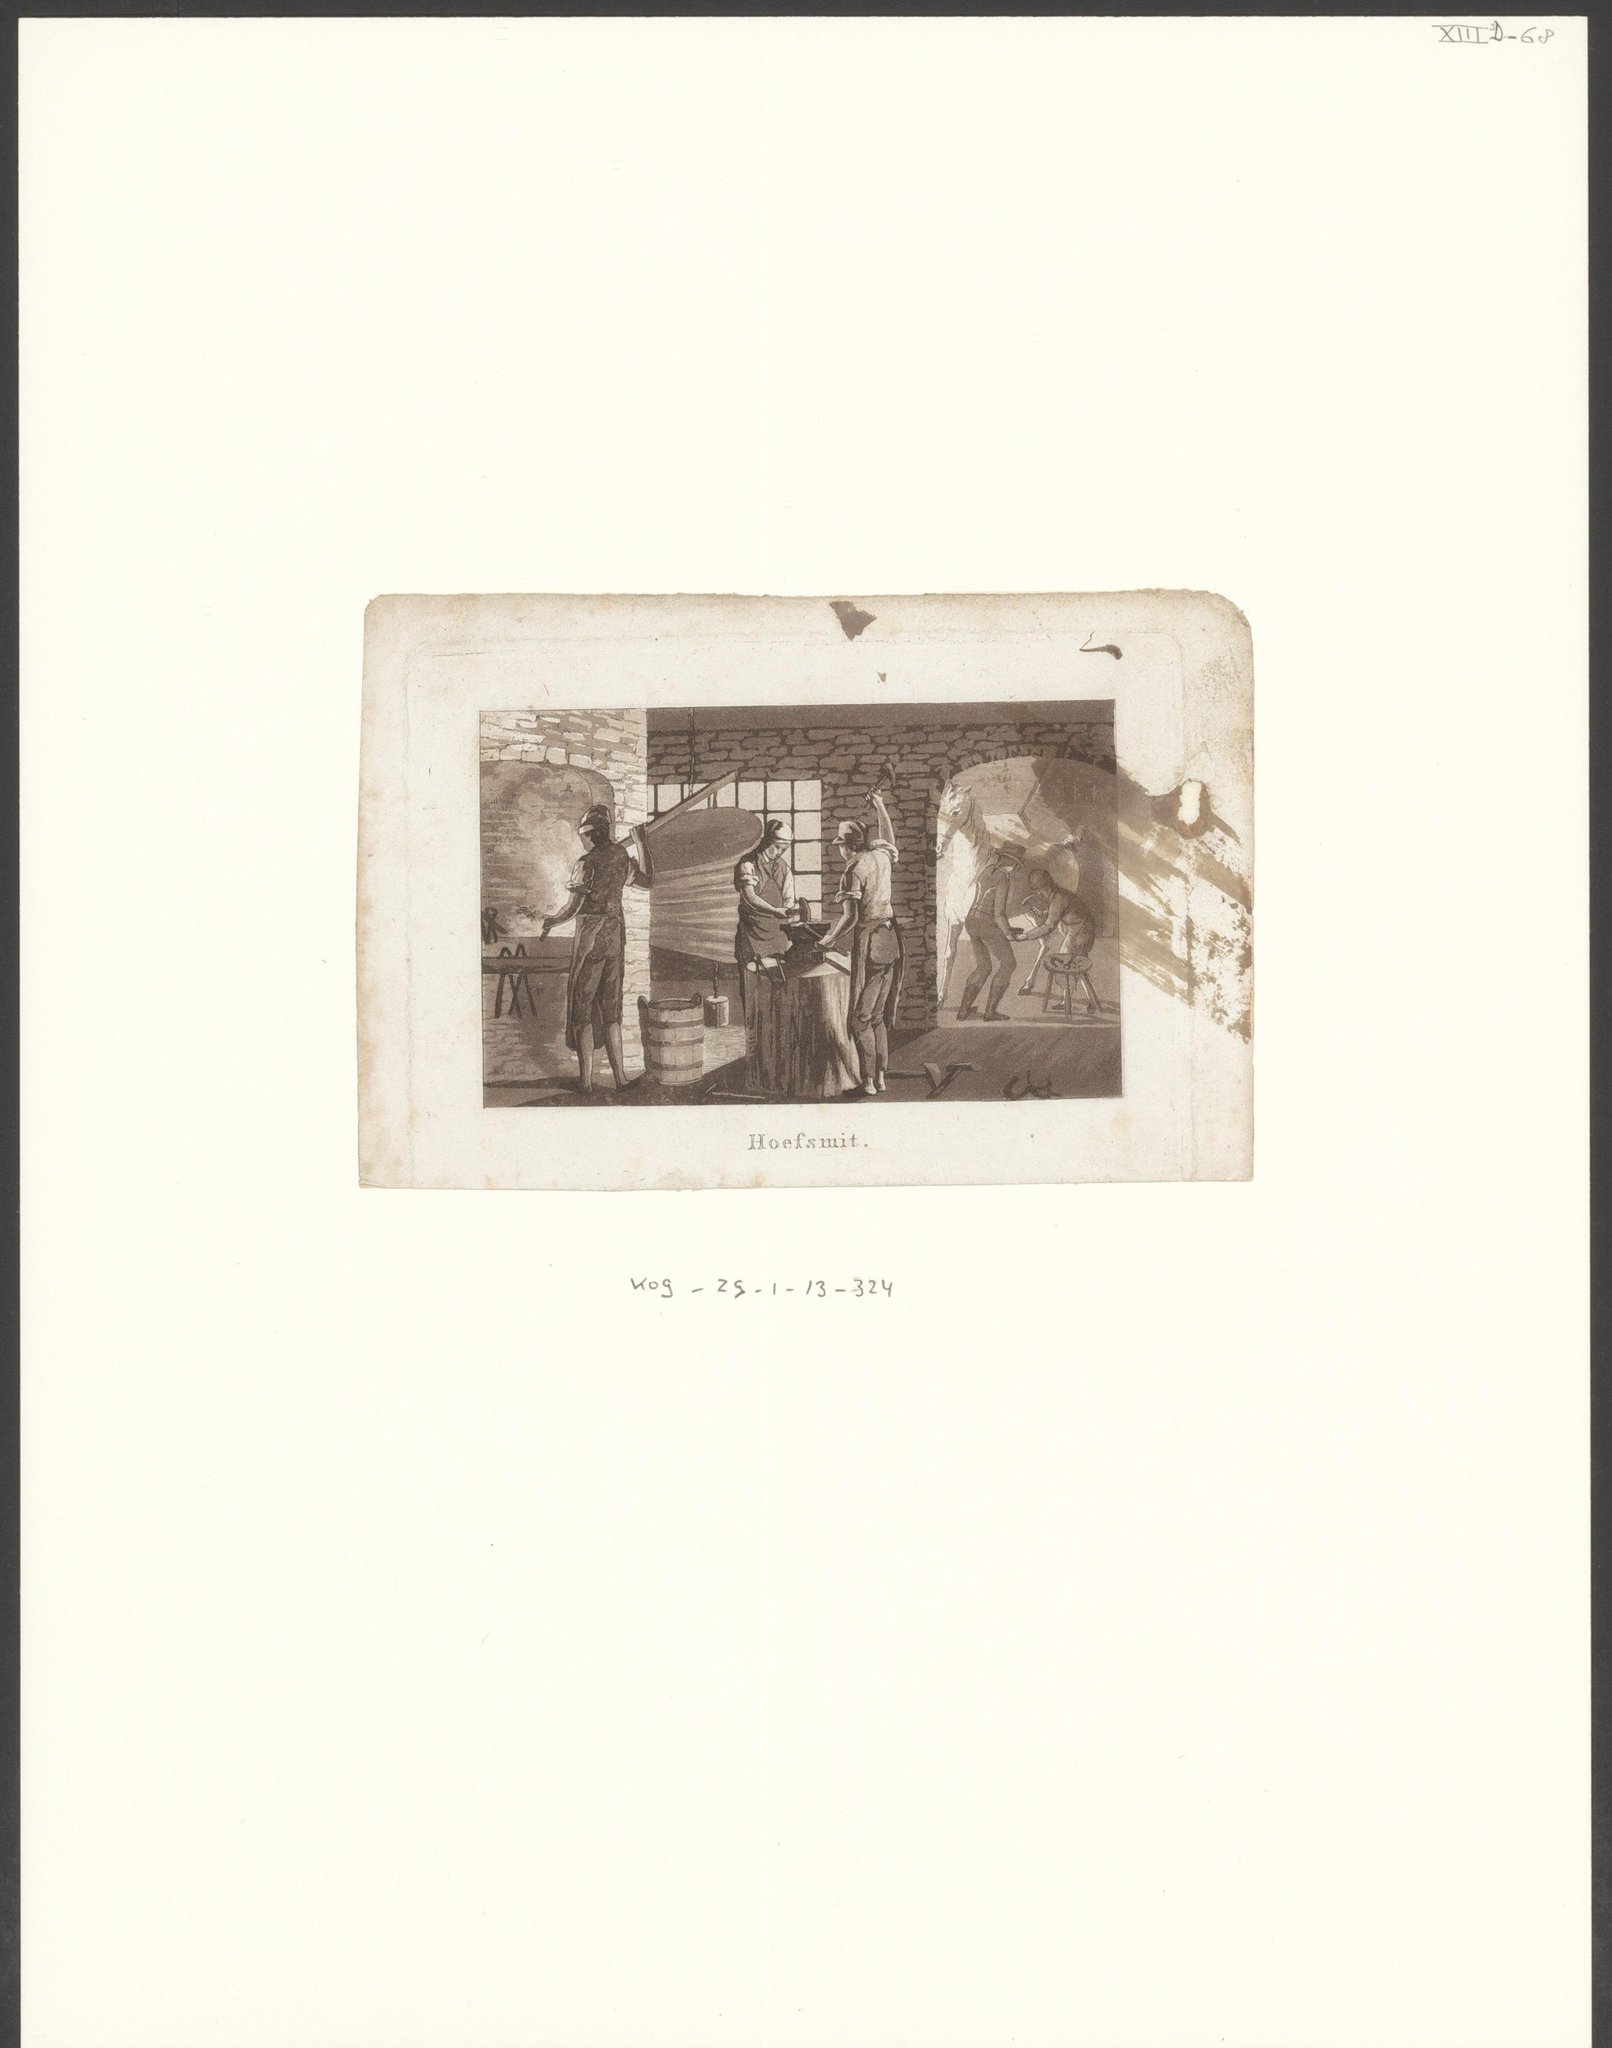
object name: print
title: Hoefsmid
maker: Anonymous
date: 1809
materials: paper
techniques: aquatint, etching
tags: farrier, shoeing-smith, horse, horseshoe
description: Interieur van de werkplaats van een hoefsmid. Achterin krijgt een paard nieuwe hoefijzers. Onderwerpsrubrieken binnen de Atlas Zeden en Gewoonten: Handel, Nijverheid en verkeer, Beroep en bedrijf, Mannelijk, Bewerkers van het metaal.